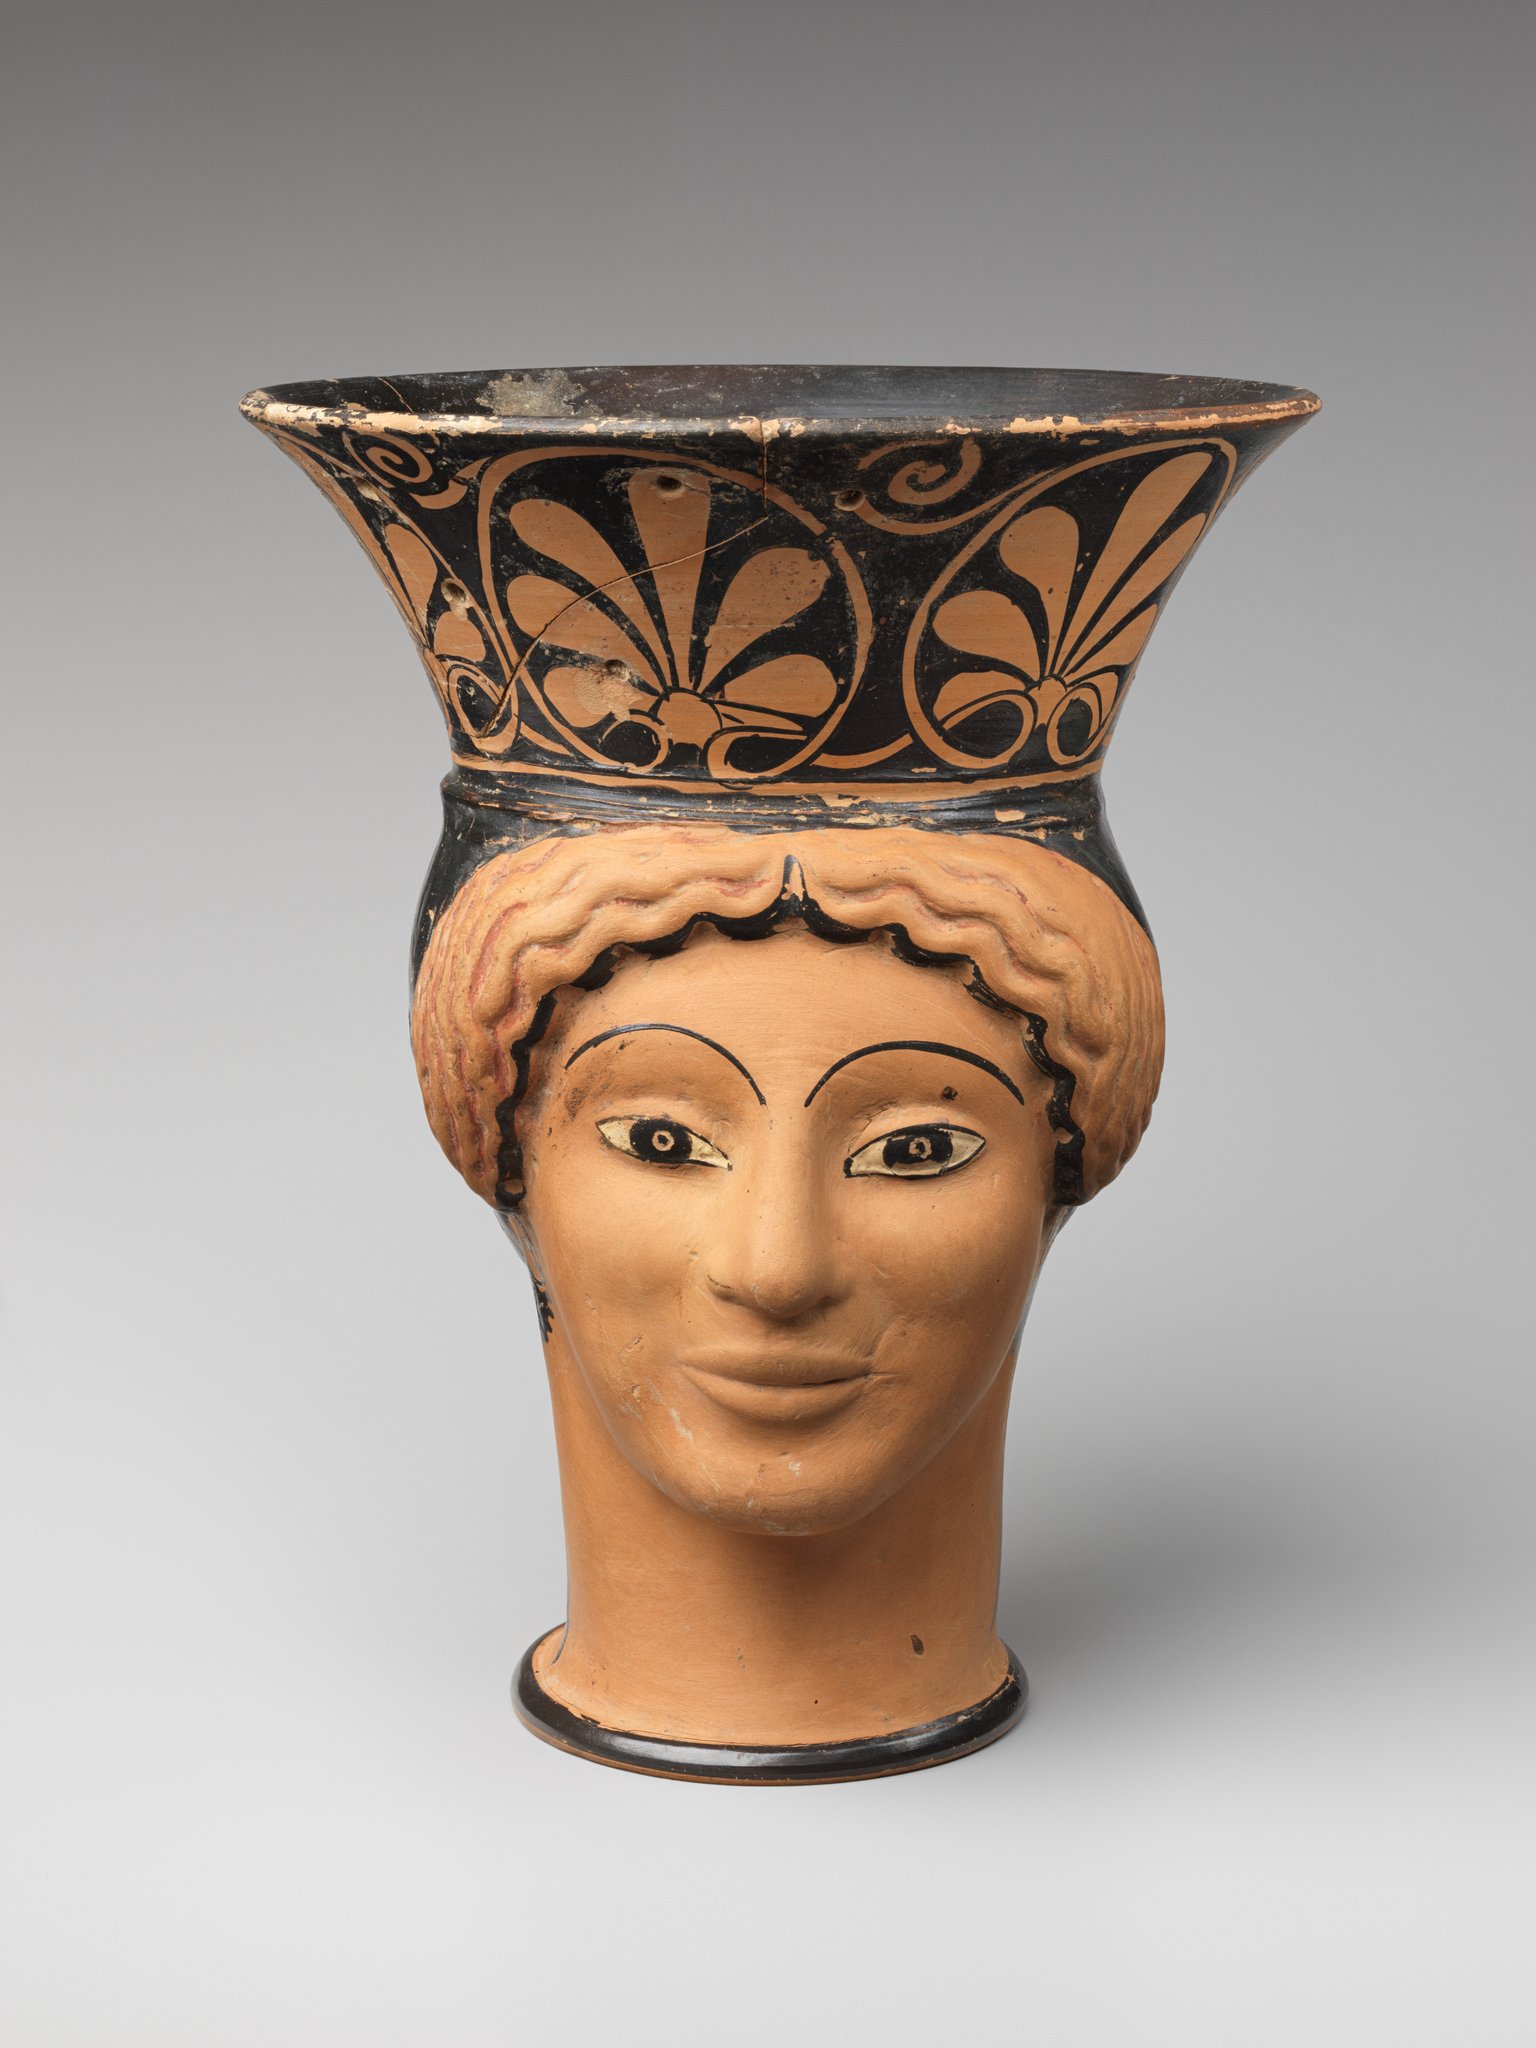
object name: mug in the form of a woman's head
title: Terracotta mug in the form of a woman's head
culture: greek, attic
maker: class g: the london class of head vases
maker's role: artist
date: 500-490 BCE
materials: terracotta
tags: heads,women